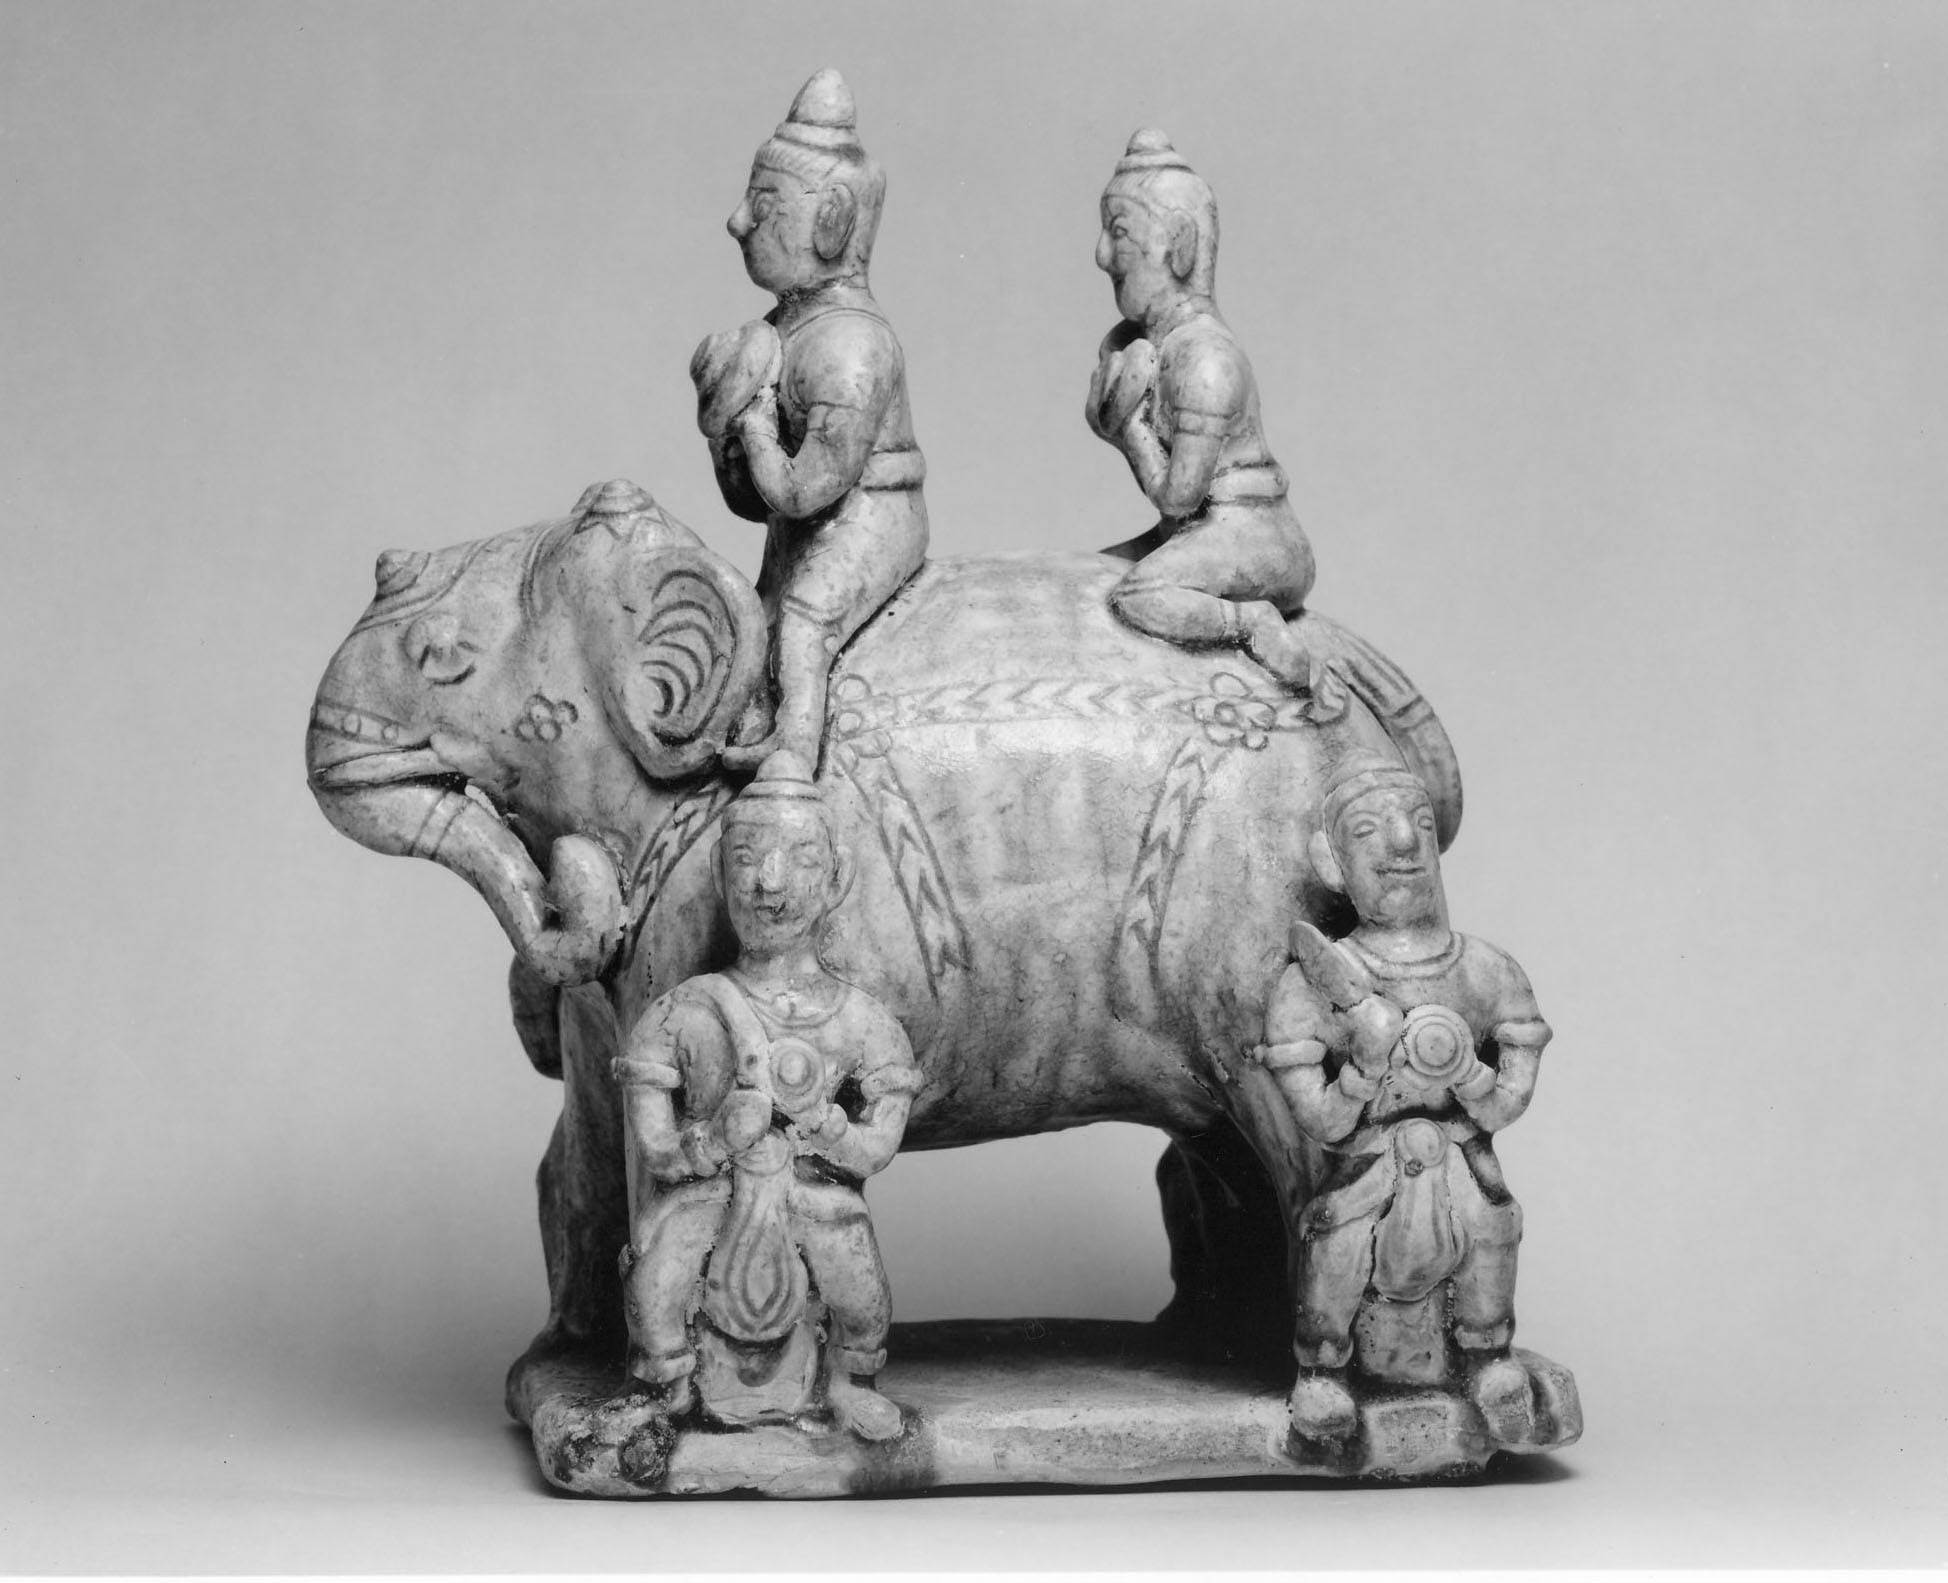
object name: group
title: Elephant with Two Riders and Four Grooms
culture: thai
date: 1301-1400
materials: earthenware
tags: men,elephants